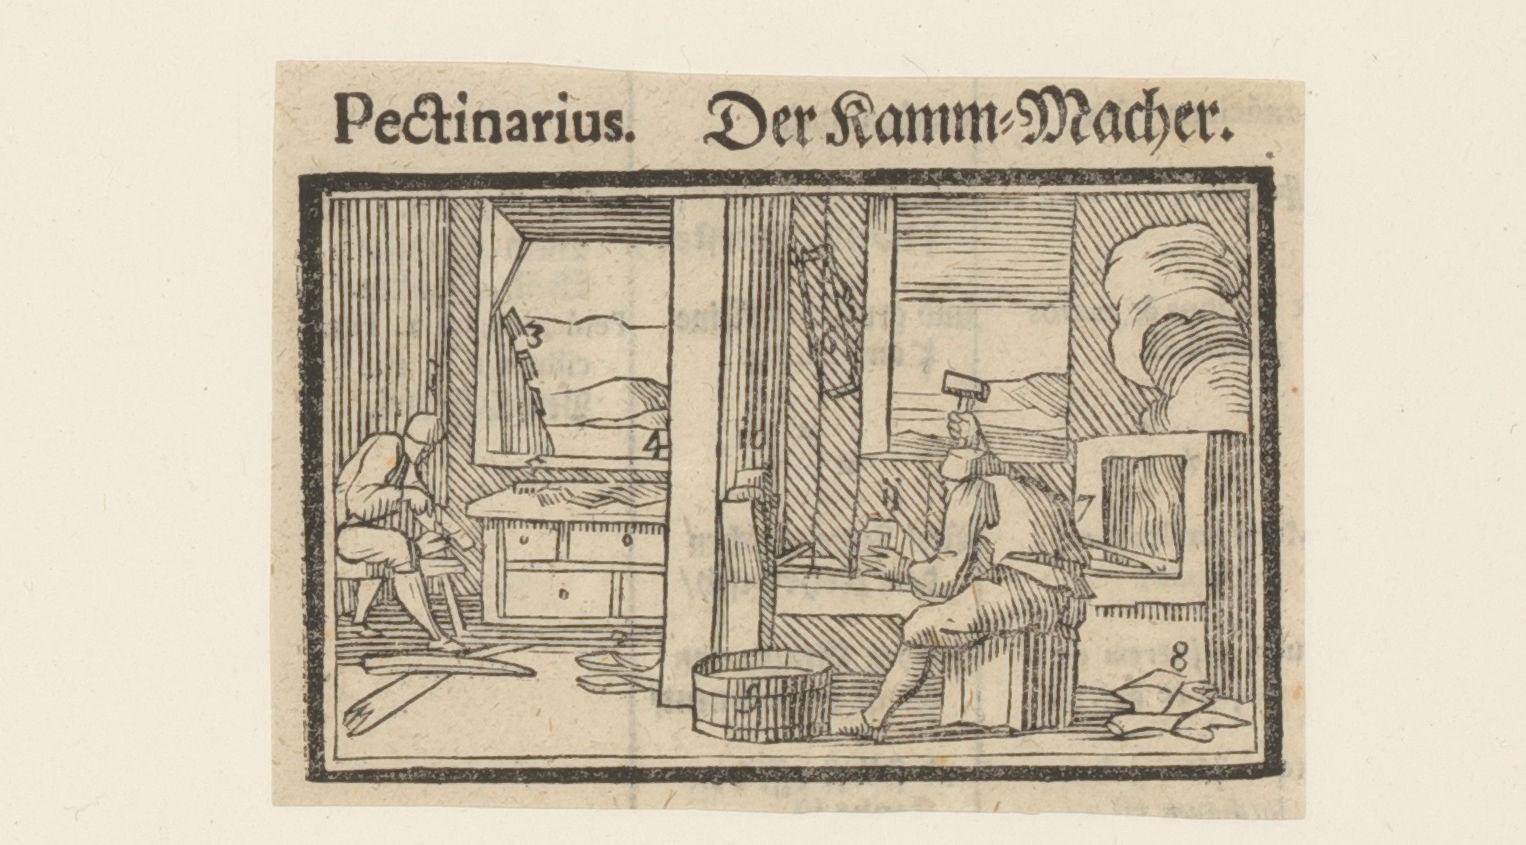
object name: print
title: Kammenmakers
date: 1719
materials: paper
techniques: letterpress printing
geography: nuremberg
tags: handicrafts, craftsman at work, carding, combing ~ textile industry, textile fabric, cloth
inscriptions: stamp, collector's mark: Lugt 1641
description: Prent uit: Comenius, Johannes Amosius. Orbis sensualium picti pars prima (...). Neurenberg: Martin Endter, 1719, dl. 2, p. 198. Prent eerder gebruikt in: Comenius, Johannes Amosius. Orbis Sensualium Picti denuo aucti Pars Secunda (...). Neurenberg: Martin Endter, 1730, dl. 2.